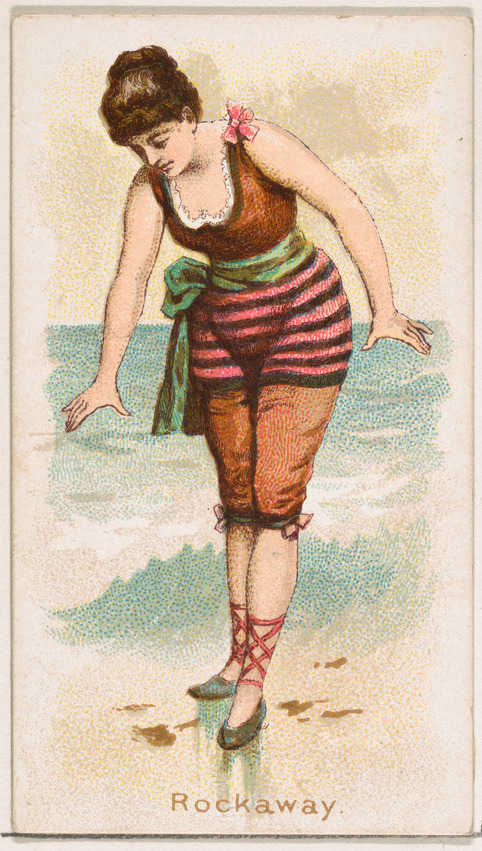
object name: print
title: Rockaway, from the Fancy Bathers series (N187) issued by Wm. S. Kimball & Co.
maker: william s. kimball & company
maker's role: publisher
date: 1889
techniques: color lithograph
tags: women